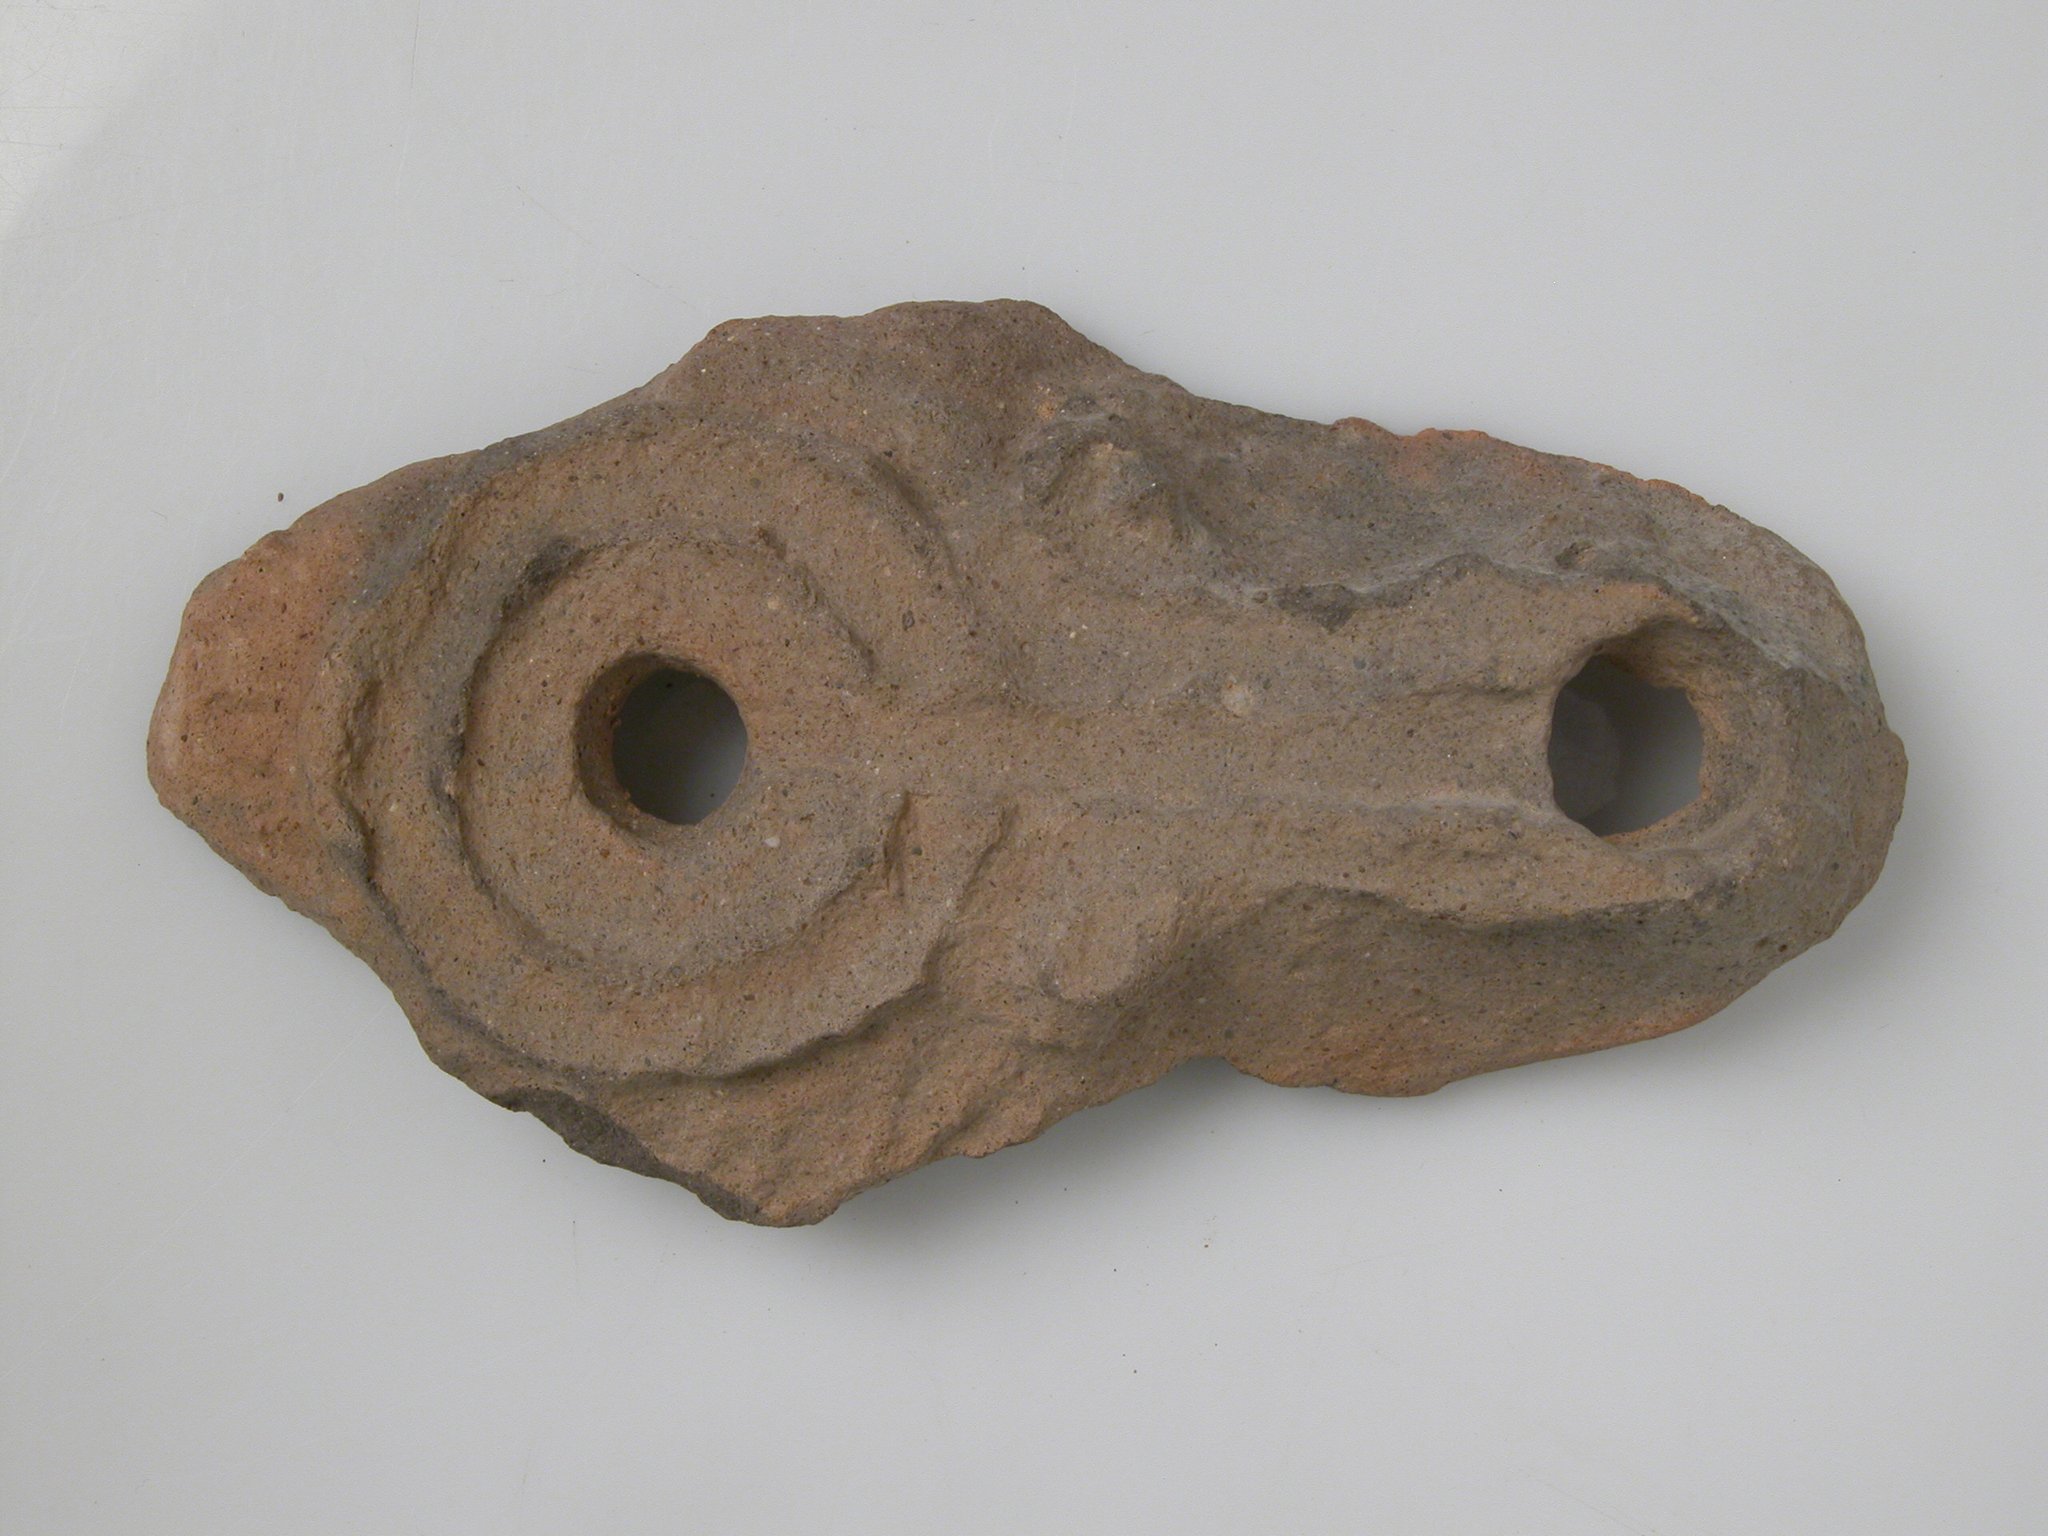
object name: lamp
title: Oil Lamp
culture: coptic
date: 301-700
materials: earthenware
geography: egypt